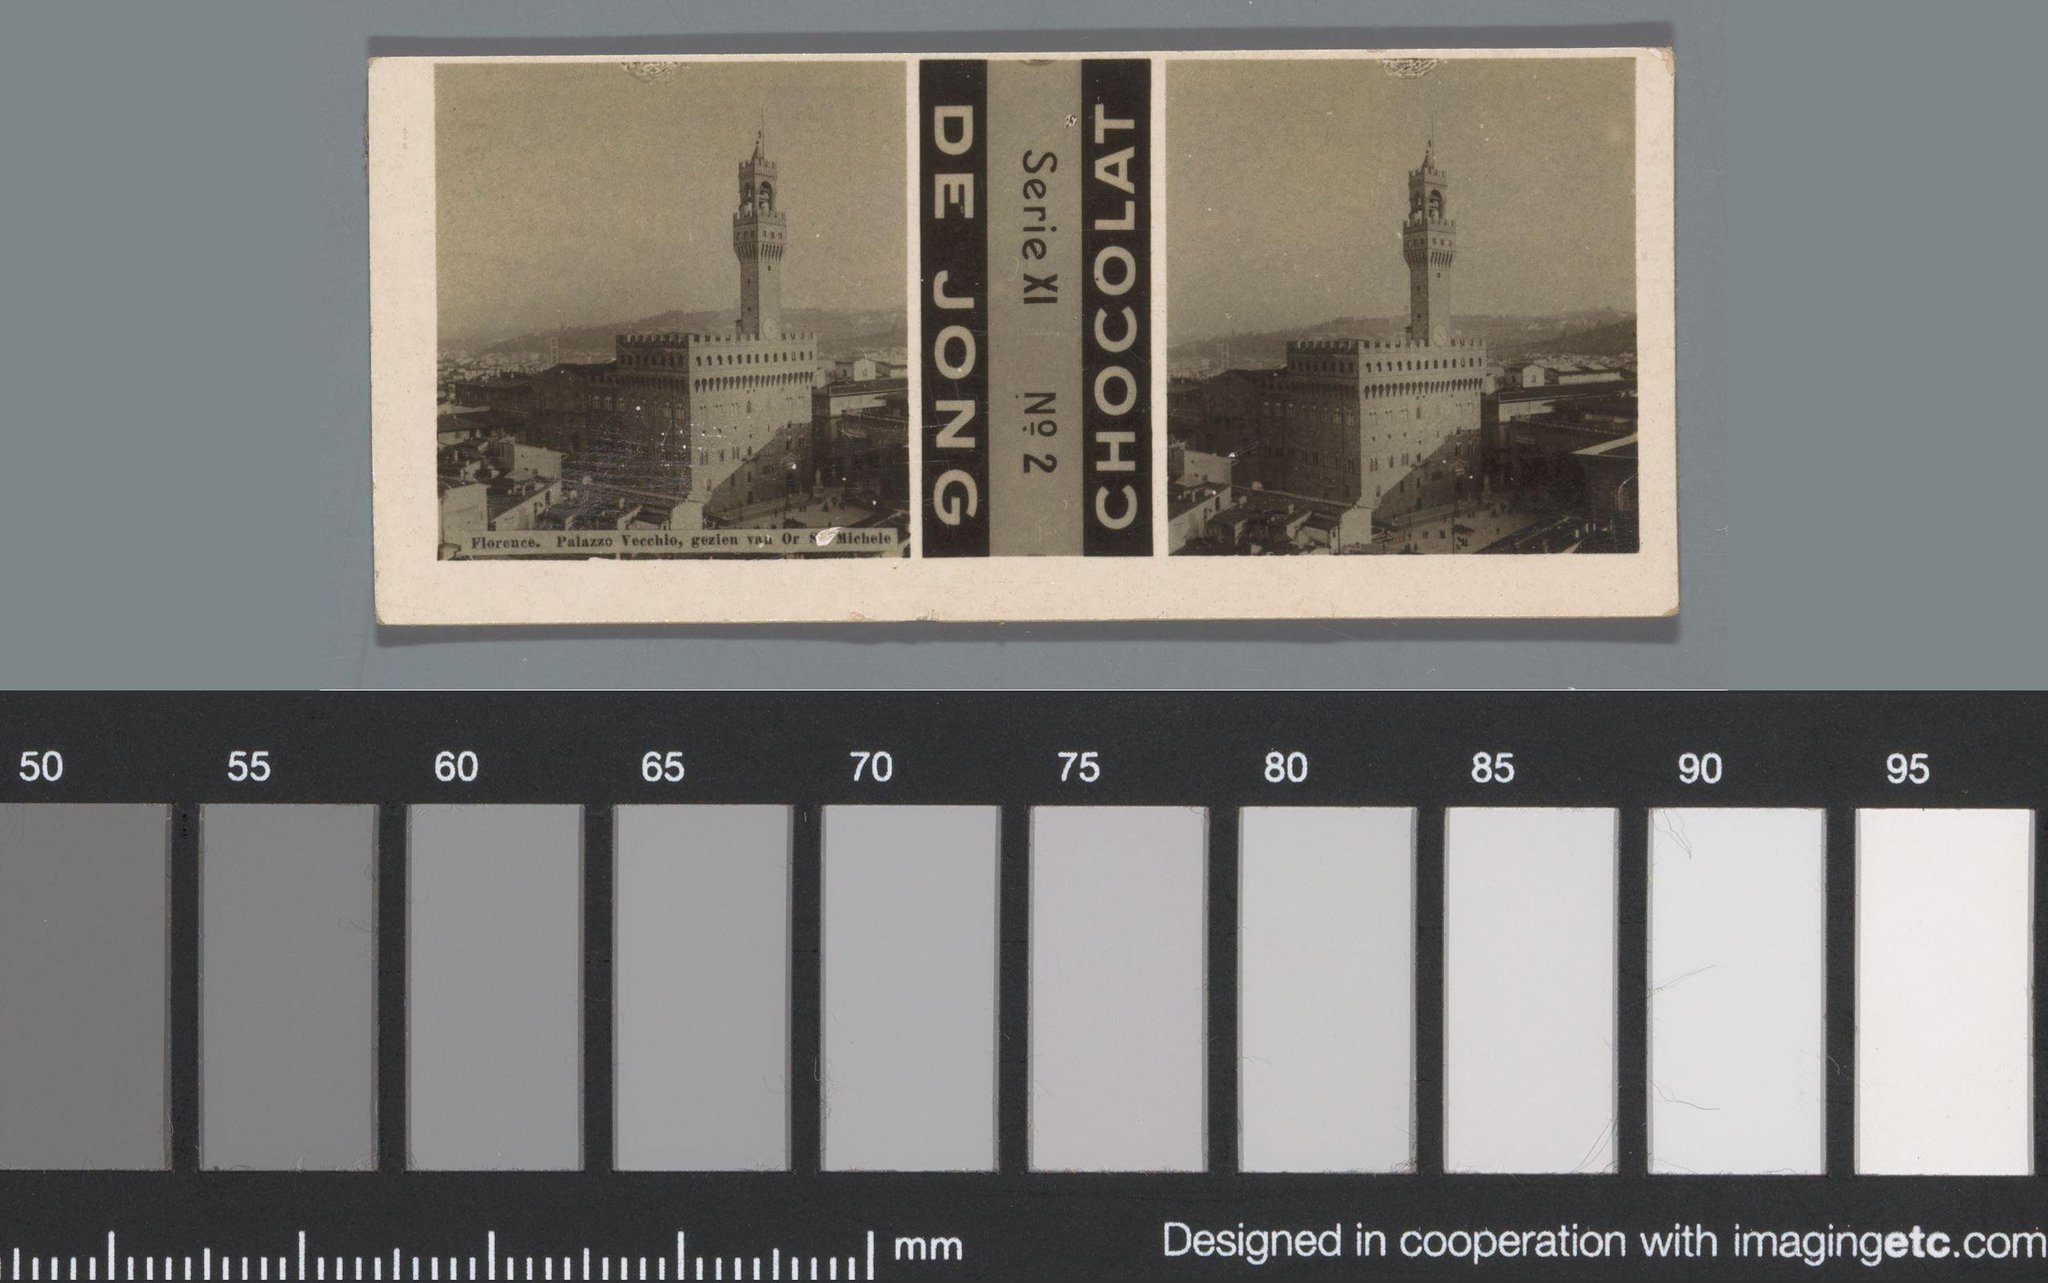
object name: stereograph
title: Gezicht op het Palazzo Vecchio te Florence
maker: Anonymous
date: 1900-1910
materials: cardboard, photographic support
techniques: gelatin silver print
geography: florence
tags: façade (of house or building)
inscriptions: number: ‘Serie XI No 2’, inscription: ‘De Jong Chocolat’